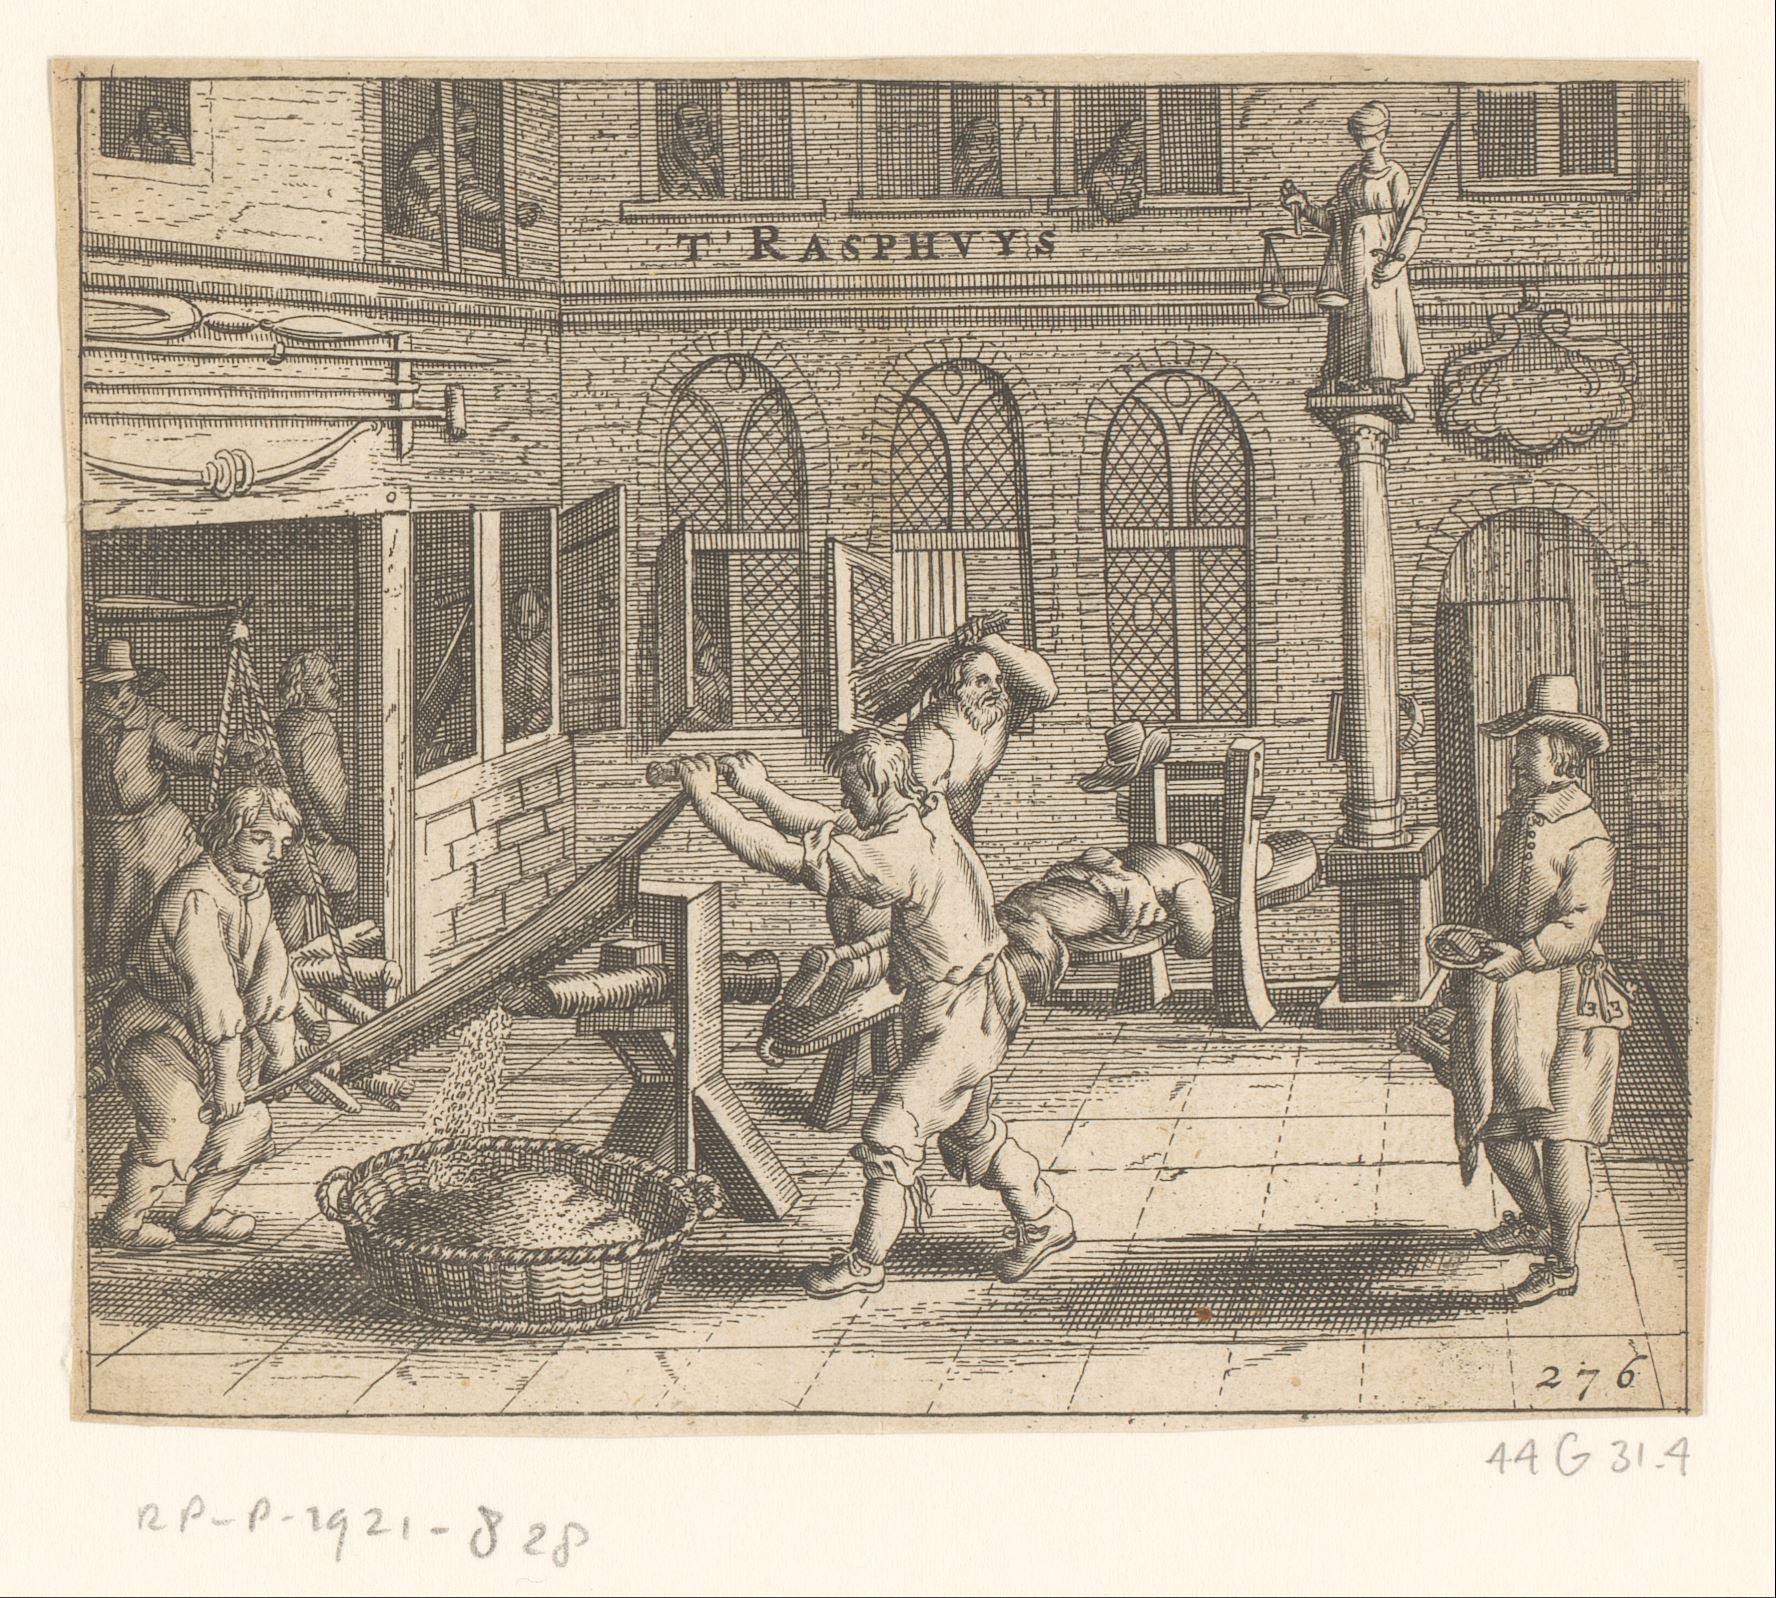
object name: print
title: T'Rasphuys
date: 1662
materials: paper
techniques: engraving, etching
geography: northern netherlands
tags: prison, jail, (prisoners) in the prison yard, justitia (justice) as roman personification, workhouse, penal camp, penitentiary, chain gang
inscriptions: collector's mark: Lugt 2228, collector's mark: Lugt 2233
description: Prent uit: Fockens, Melchior. Beschrijvinge Der wijdt-vermaarde Koop-stadt Amstelredam, Van hare eerste beginselen, oude Voor-rechten, en verscheyde Vergrootingen (…). 1e druk. Amsterdam: Marcus Willemsz. Doornick, 1662. Prent in huidige staat ook gebruikt in de tweede druk (1662). Tweede staat van prent gebruikt in de derde druk van 1664. Derde staat met Franse titel gebruikt in publicatie uit 1665. Vierde staat (genummerd: 34) gebruikt in verschillende zeventiende- en achttiende-eeuwse publicaties.